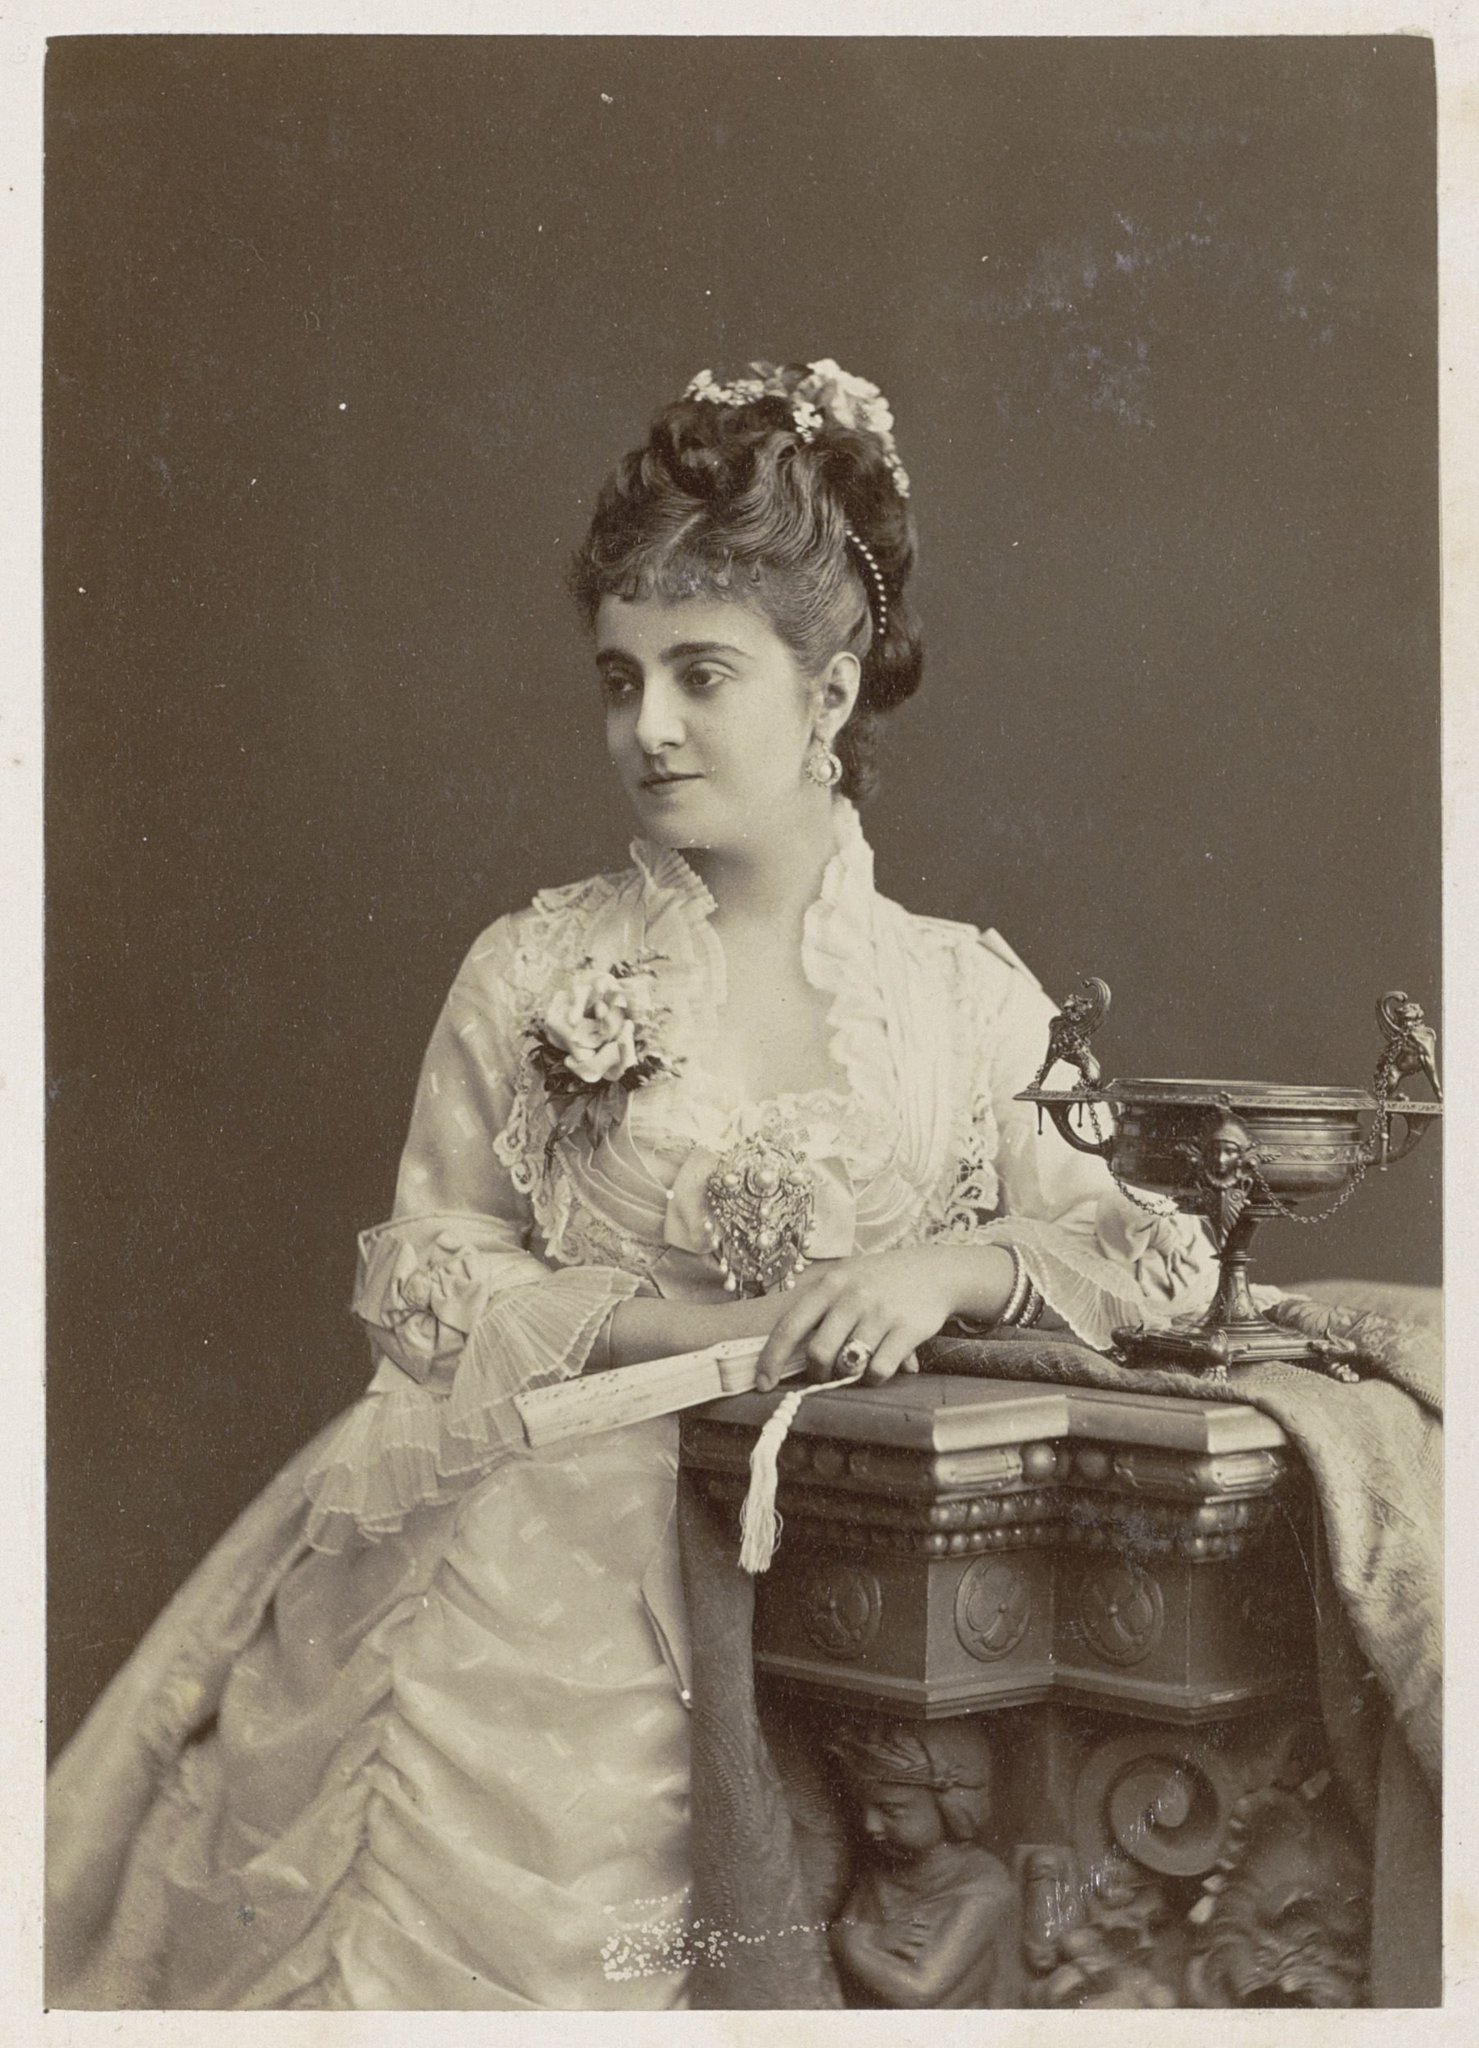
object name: photograph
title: Studioportret van operazangeres Adelina Patti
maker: Anonymous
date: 1878-1890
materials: photographic support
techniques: albumen print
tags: mug, beaker, goblet, anonymous historical person portrayed - bb - woman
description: Studioportret van operazangeres Adelina Patti, zittend naast een tazza met waaier in de hand. Onderdeel van Reisalbum Europese steden, vermoedelijk Zweeds.